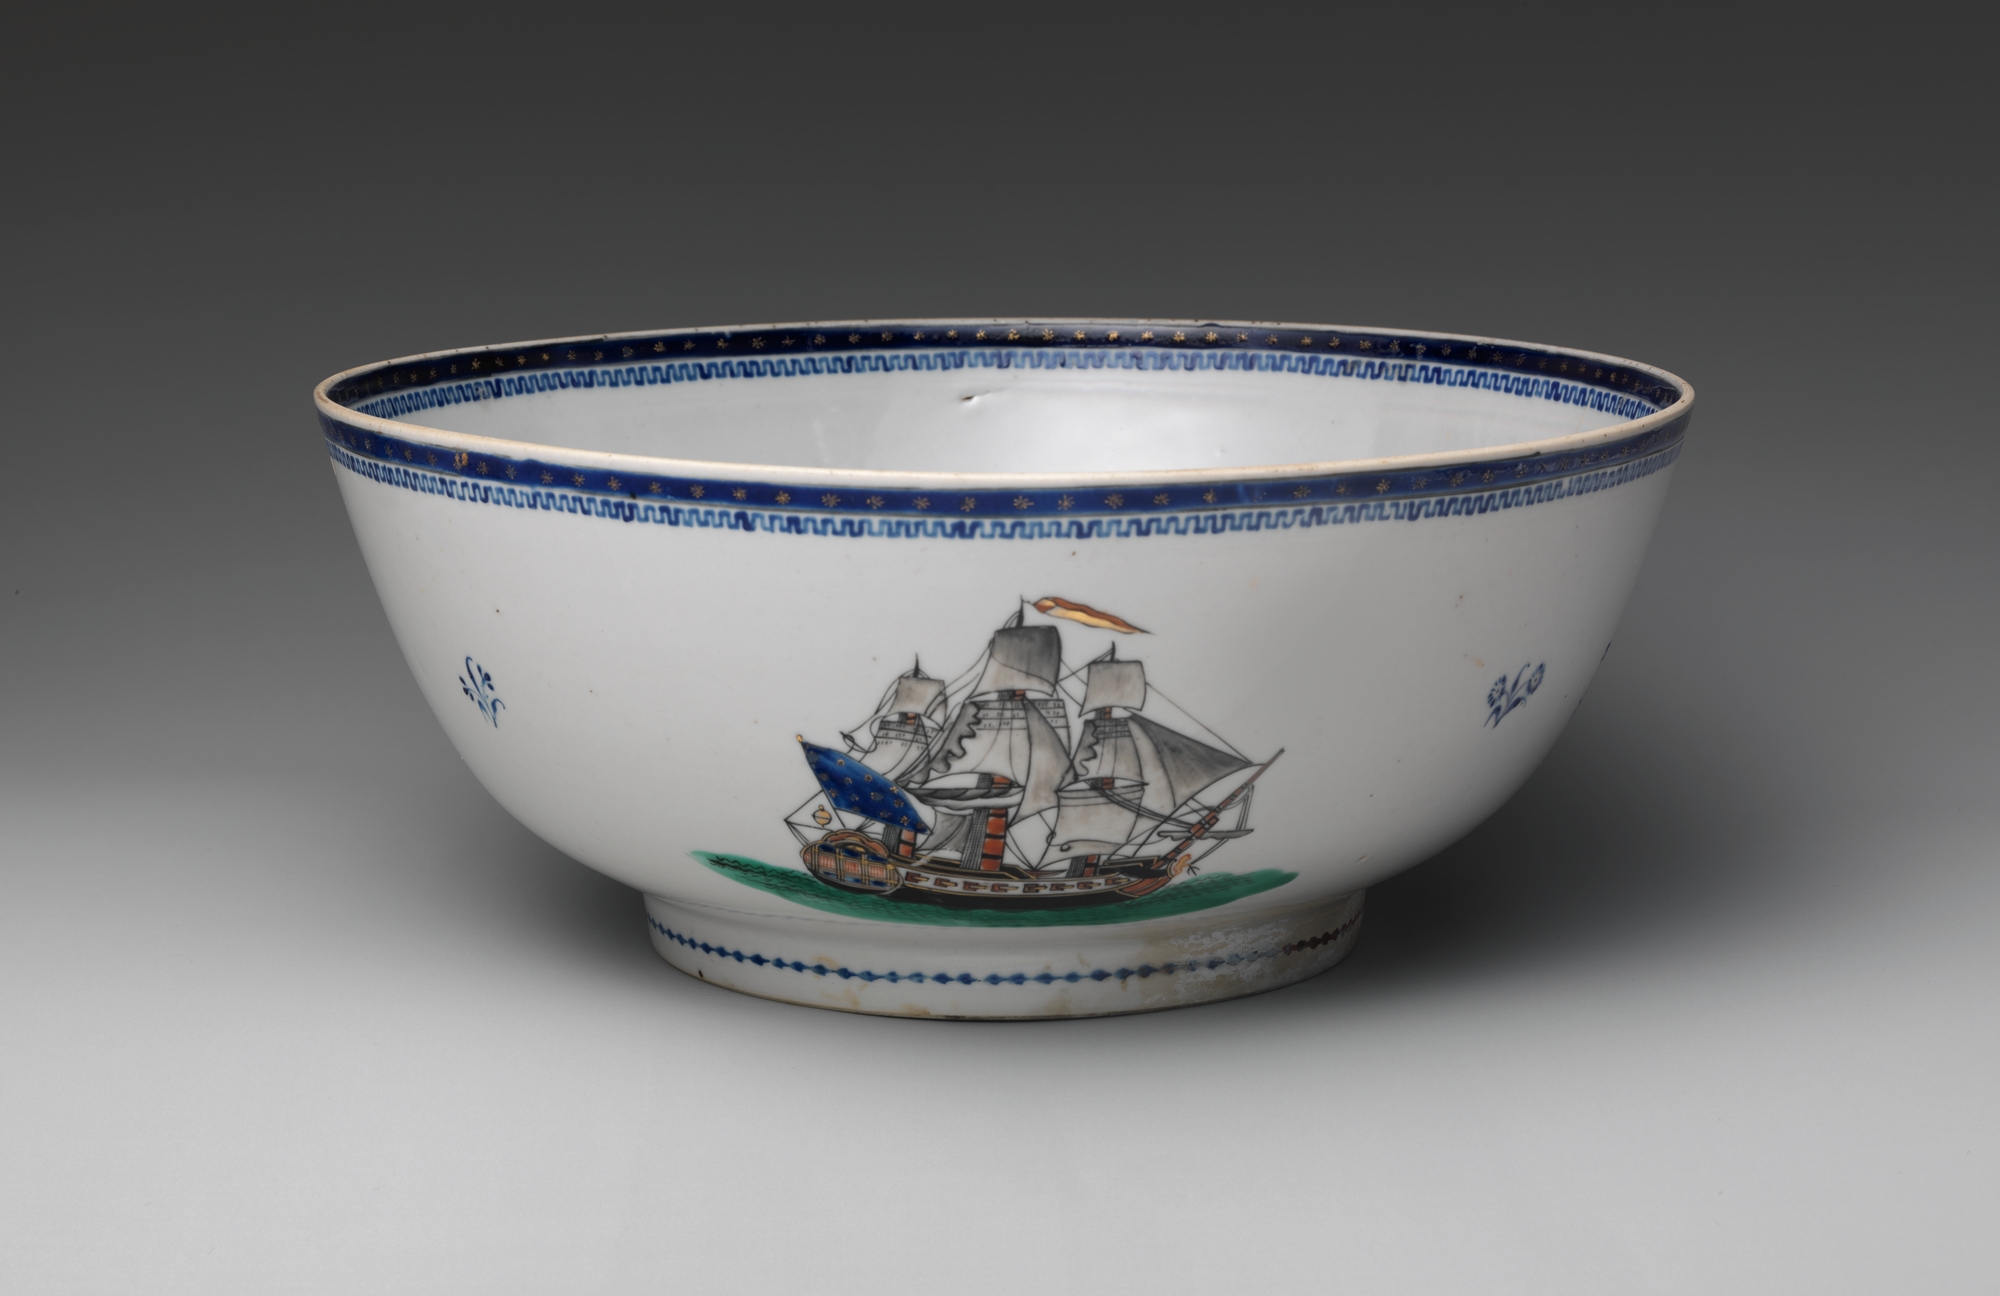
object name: bowl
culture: chinese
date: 1770-1800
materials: porcelain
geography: china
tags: ships